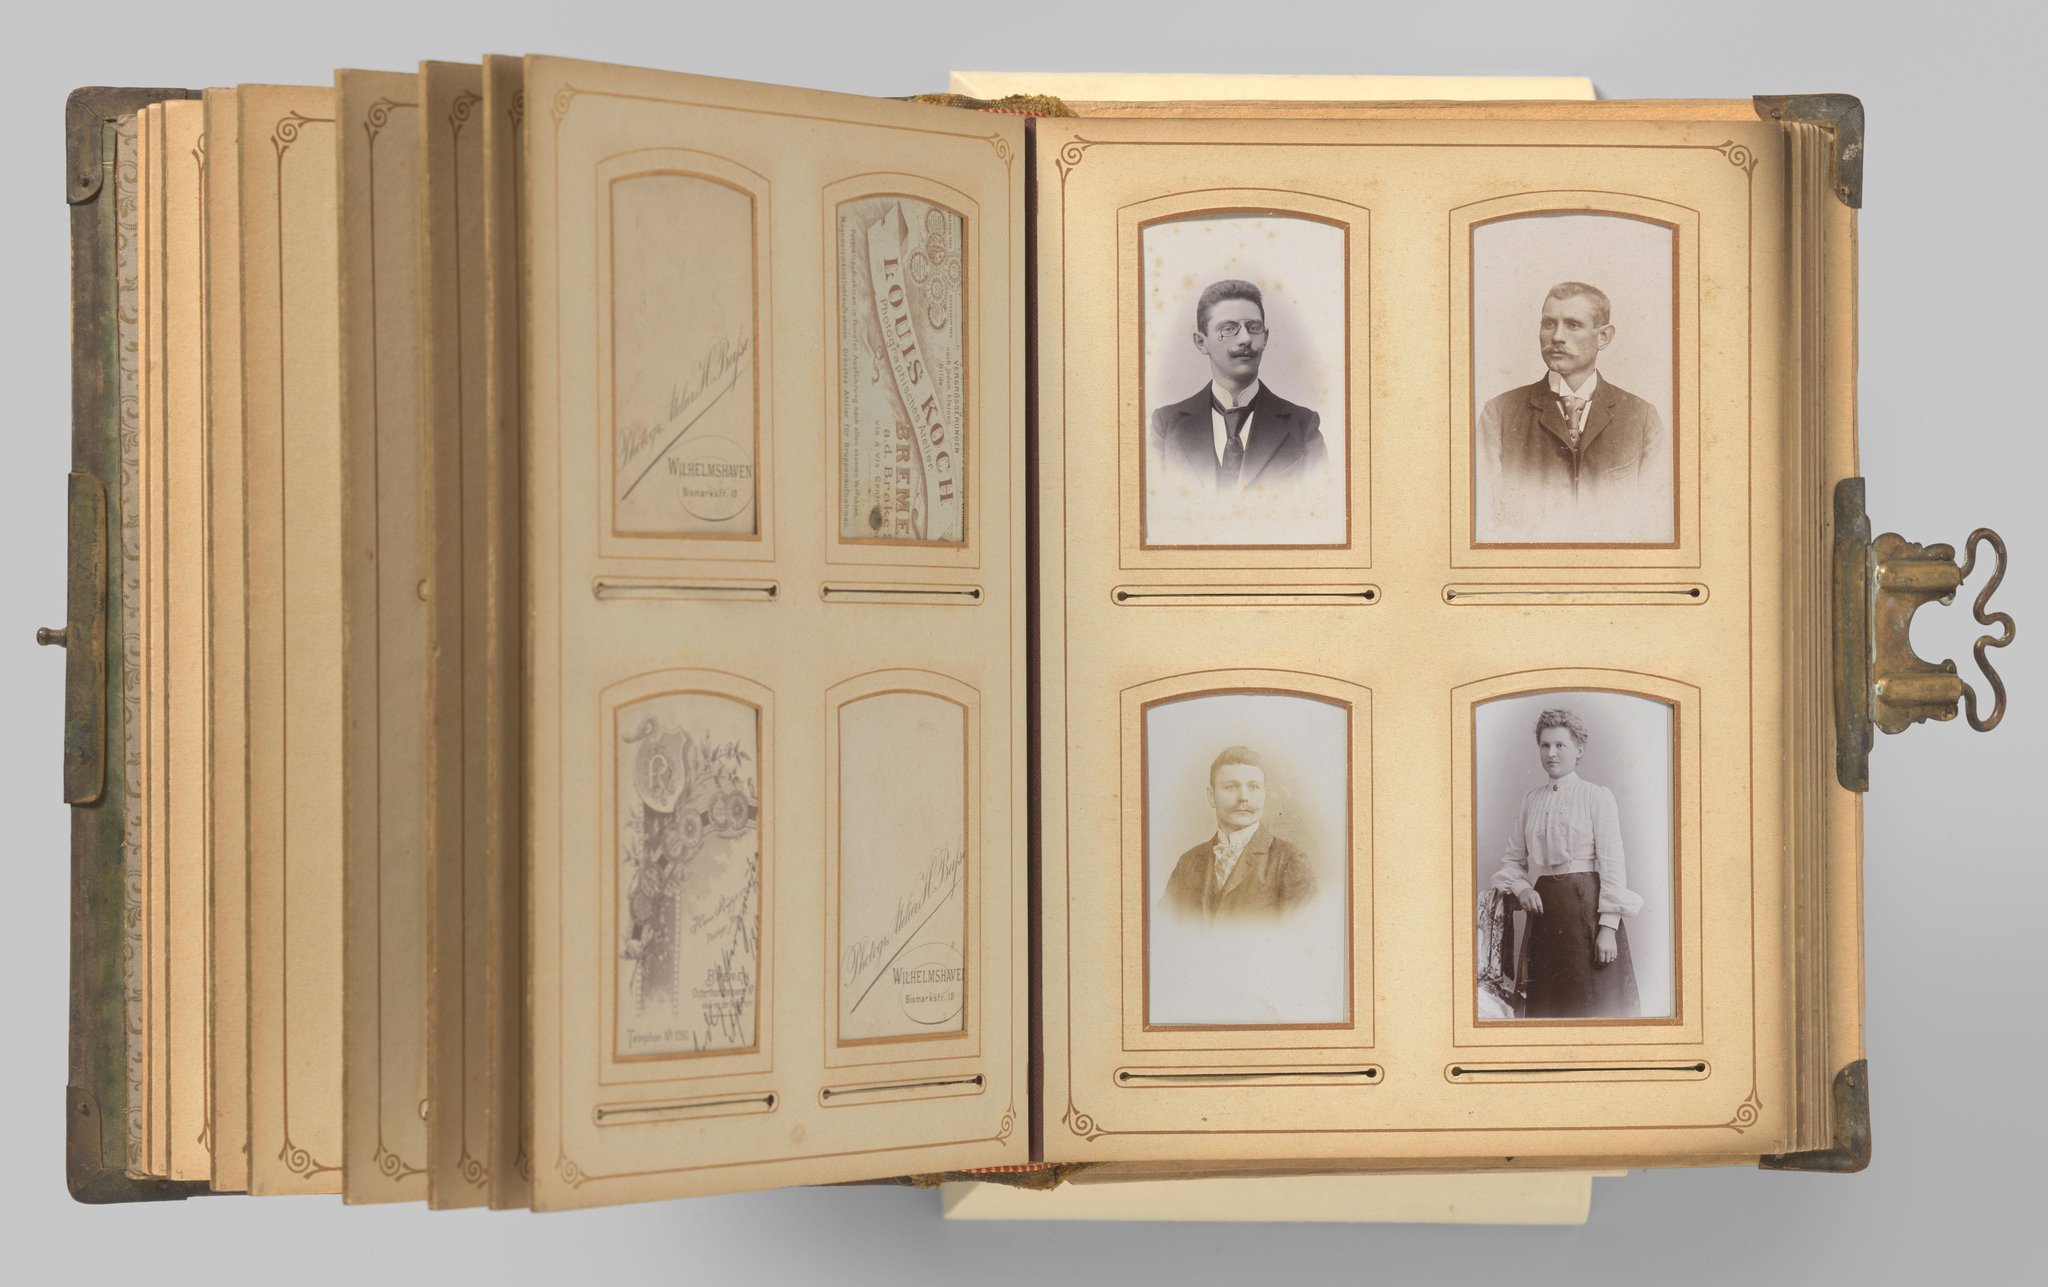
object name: carte de visite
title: Portret van een staande jonge vrouw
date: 1900-1910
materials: cardboard, photographic support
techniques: collodion silver print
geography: berlin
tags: adolescent, young woman, maiden, historical persons - bb - woman, standing figure - aa - female human figure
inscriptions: inscription: ‘GLOBUS ATELIER/ BERLIN W./ LEIPZIGER STR. 132/135.’